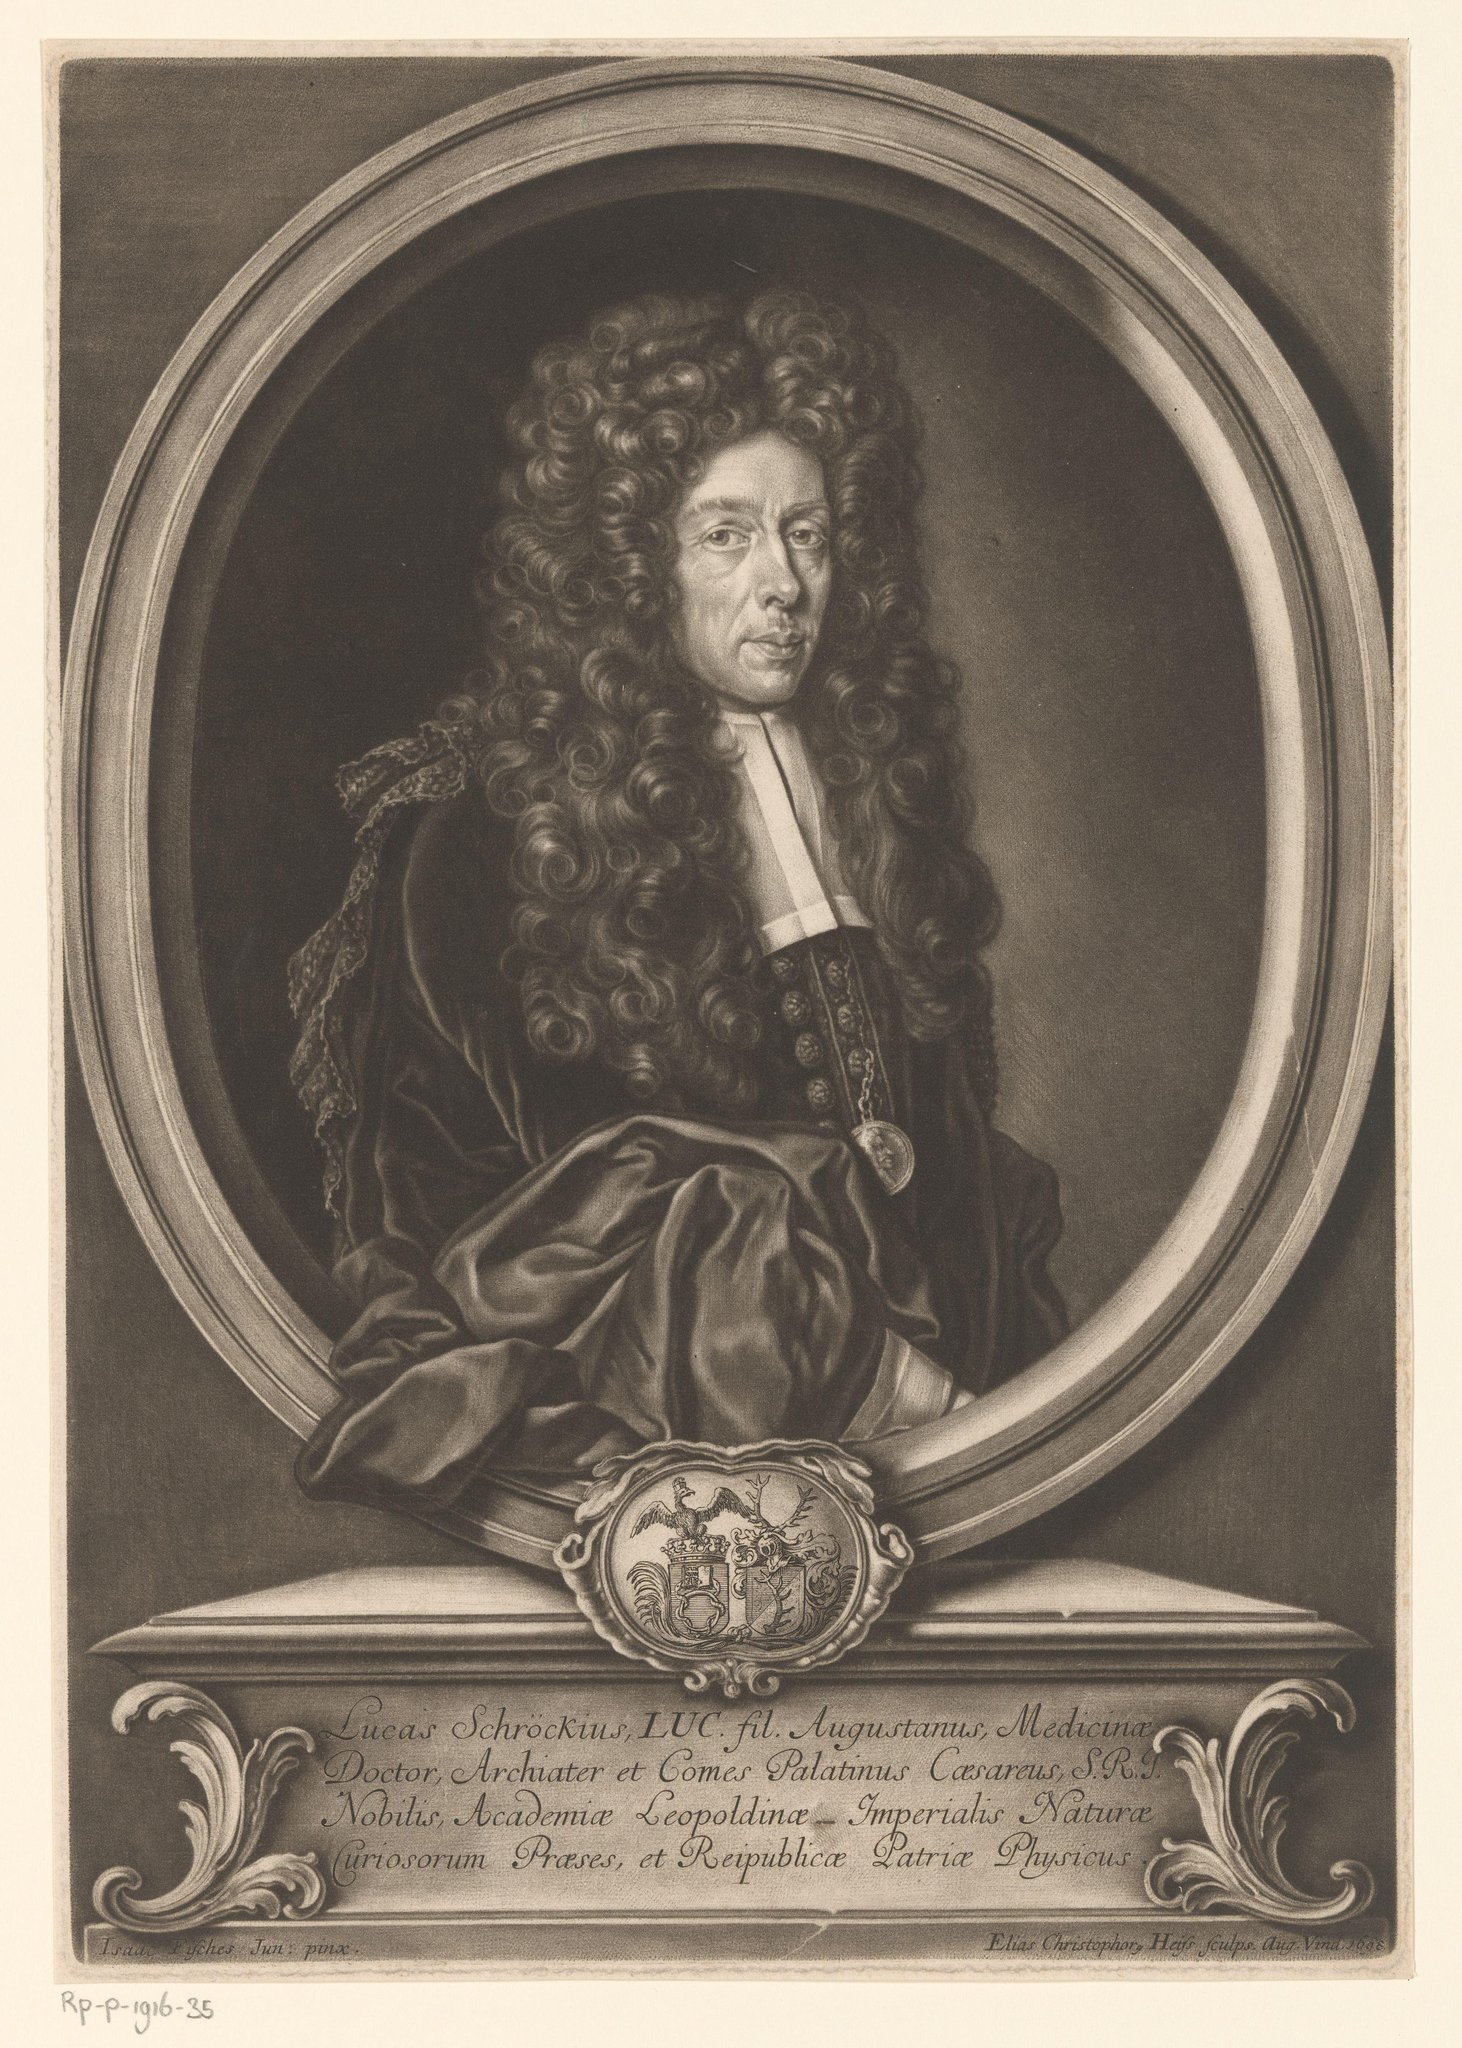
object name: print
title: Portret van Lucas Schröck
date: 1698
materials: paper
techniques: etching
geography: augsburg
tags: augsburg, lucas schröck (1646-1730), historical persons, armorial bearing, heraldry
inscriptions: collector's mark: Lugt 2228